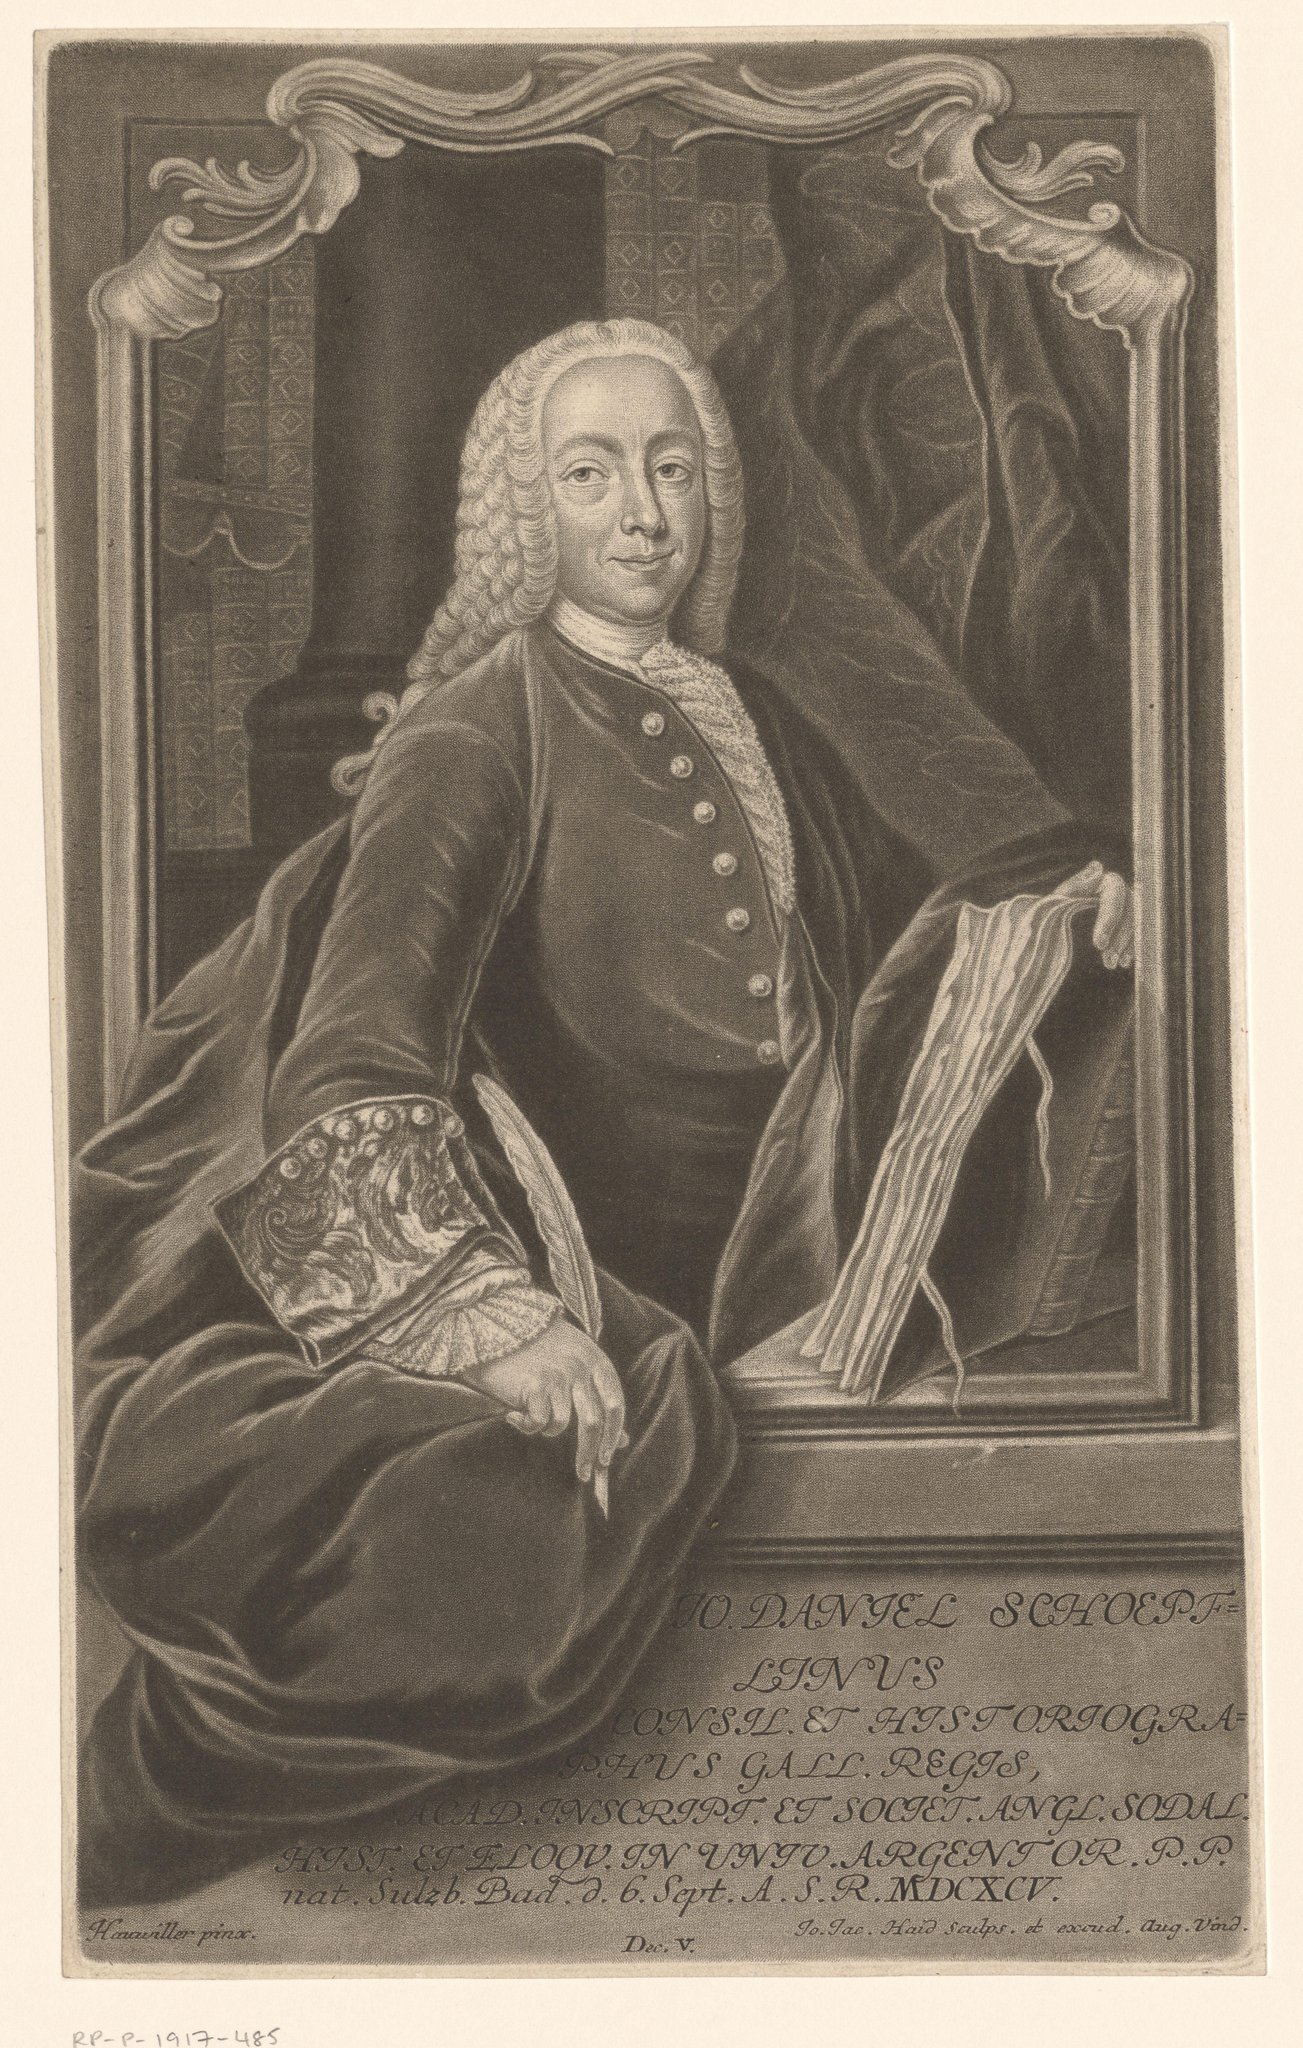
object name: print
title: Portret van Johann Daniel Schöpflin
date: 1746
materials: paper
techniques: engraving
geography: augsburg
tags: historical persons, professor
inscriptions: collector's mark: Lugt 2228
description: Prent waarschijnlijk uit: Brucker, Johann Jakob. Bilder-sal heutiges Tages lebender, und durch Gelahrheit berühmter Schrifftsteller(...). Augsburg: Johann Jacob Haid, 1746, dl. 9.